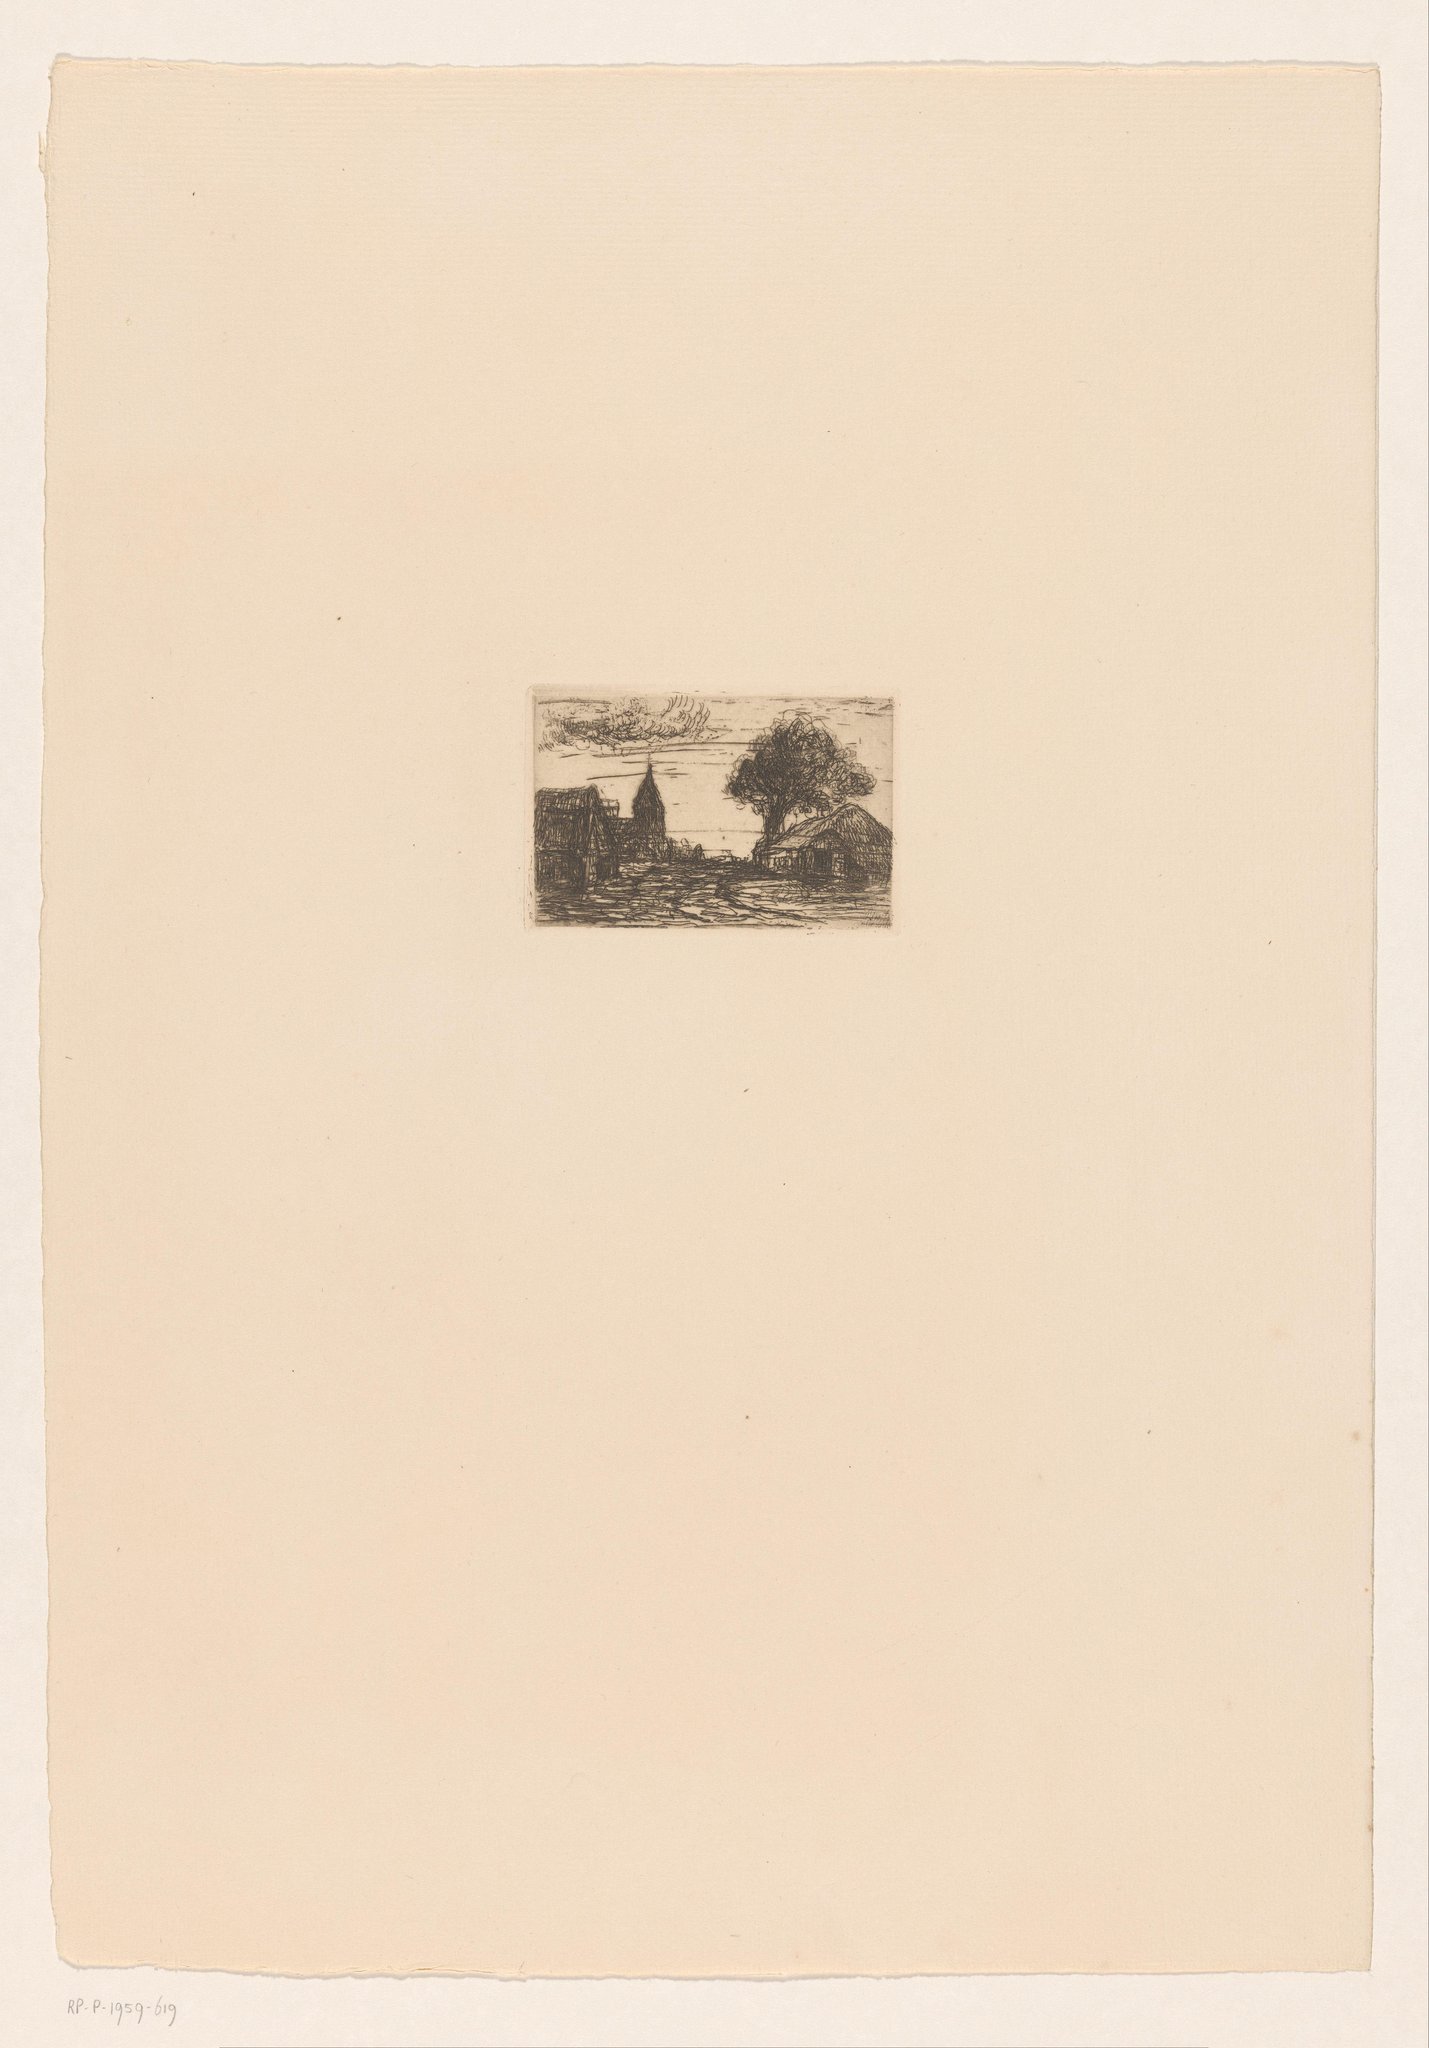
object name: print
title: Dorp in de Kempen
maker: jakob smits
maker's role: draughtsman, print maker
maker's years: 1855-1928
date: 1865-1928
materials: paper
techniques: etching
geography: netherlands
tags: prospect of village, silhouette of village, farm or solitary house in landscape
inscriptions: collector's mark: Lugt 2760, collector's mark: Lugt 2228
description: Links een kerktoren; rechts een boom naast een schuur.